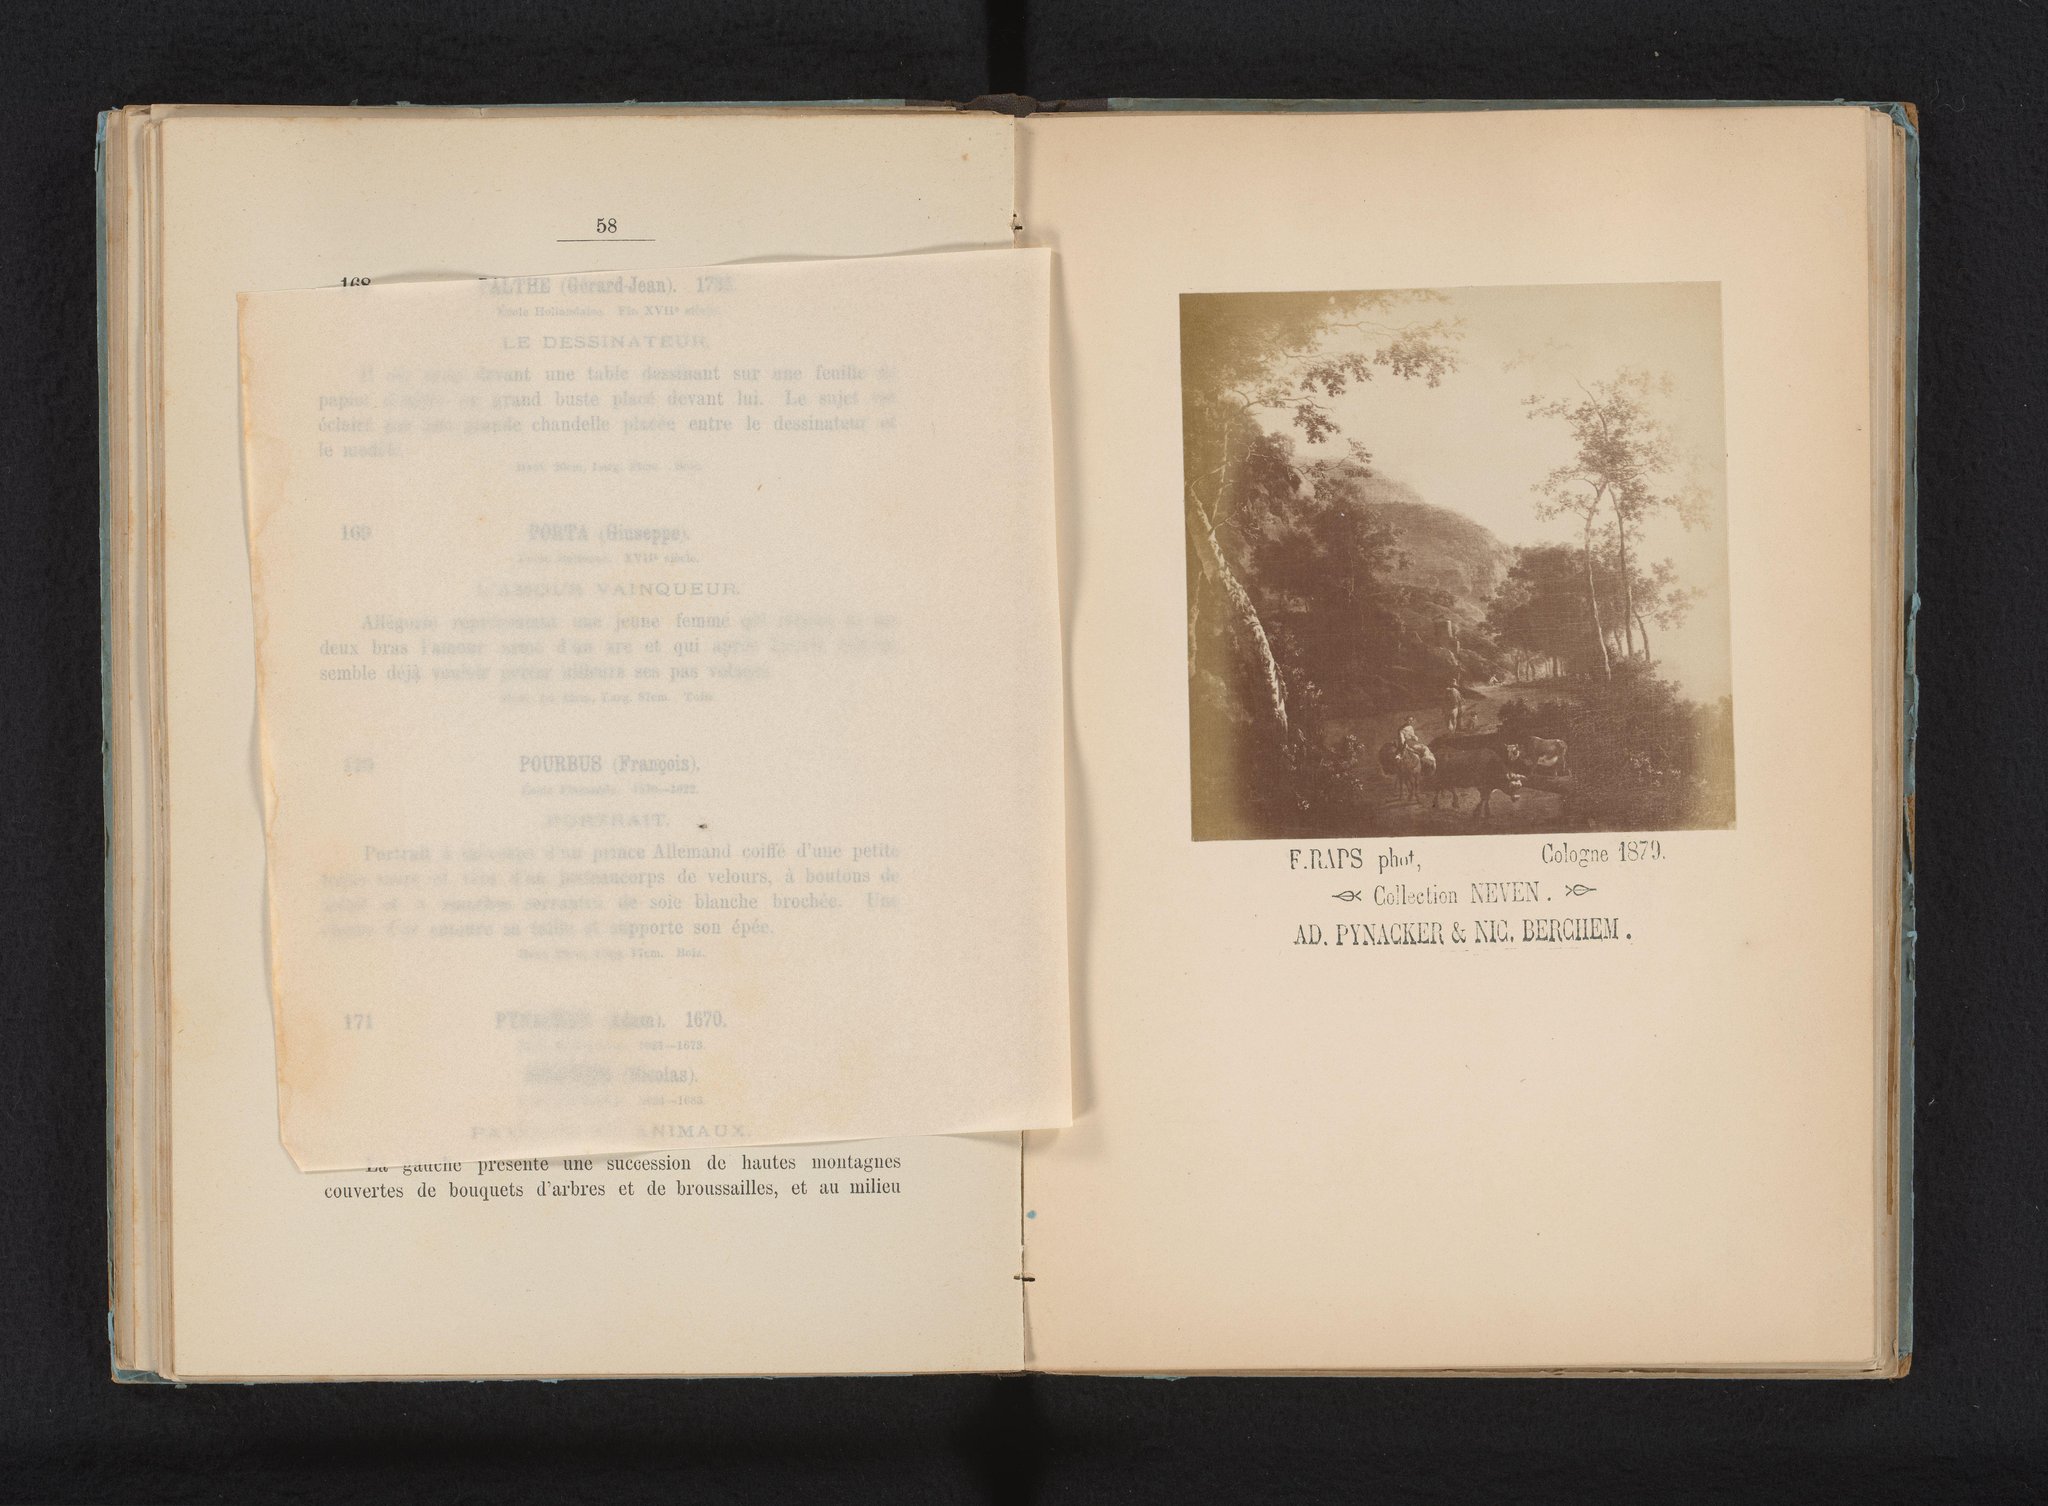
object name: photograph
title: Fotoreproductie van een schilderij van een landschap met reizigers en vee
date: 1879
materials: photographic support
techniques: albumen print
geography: cologne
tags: cattle, 'en route', traveller under way, landscapes (+ landscape with figures, staffage)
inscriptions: inscription: ‘Collection NEVEN/ Ad. Pynacker & Nic. Berghem’